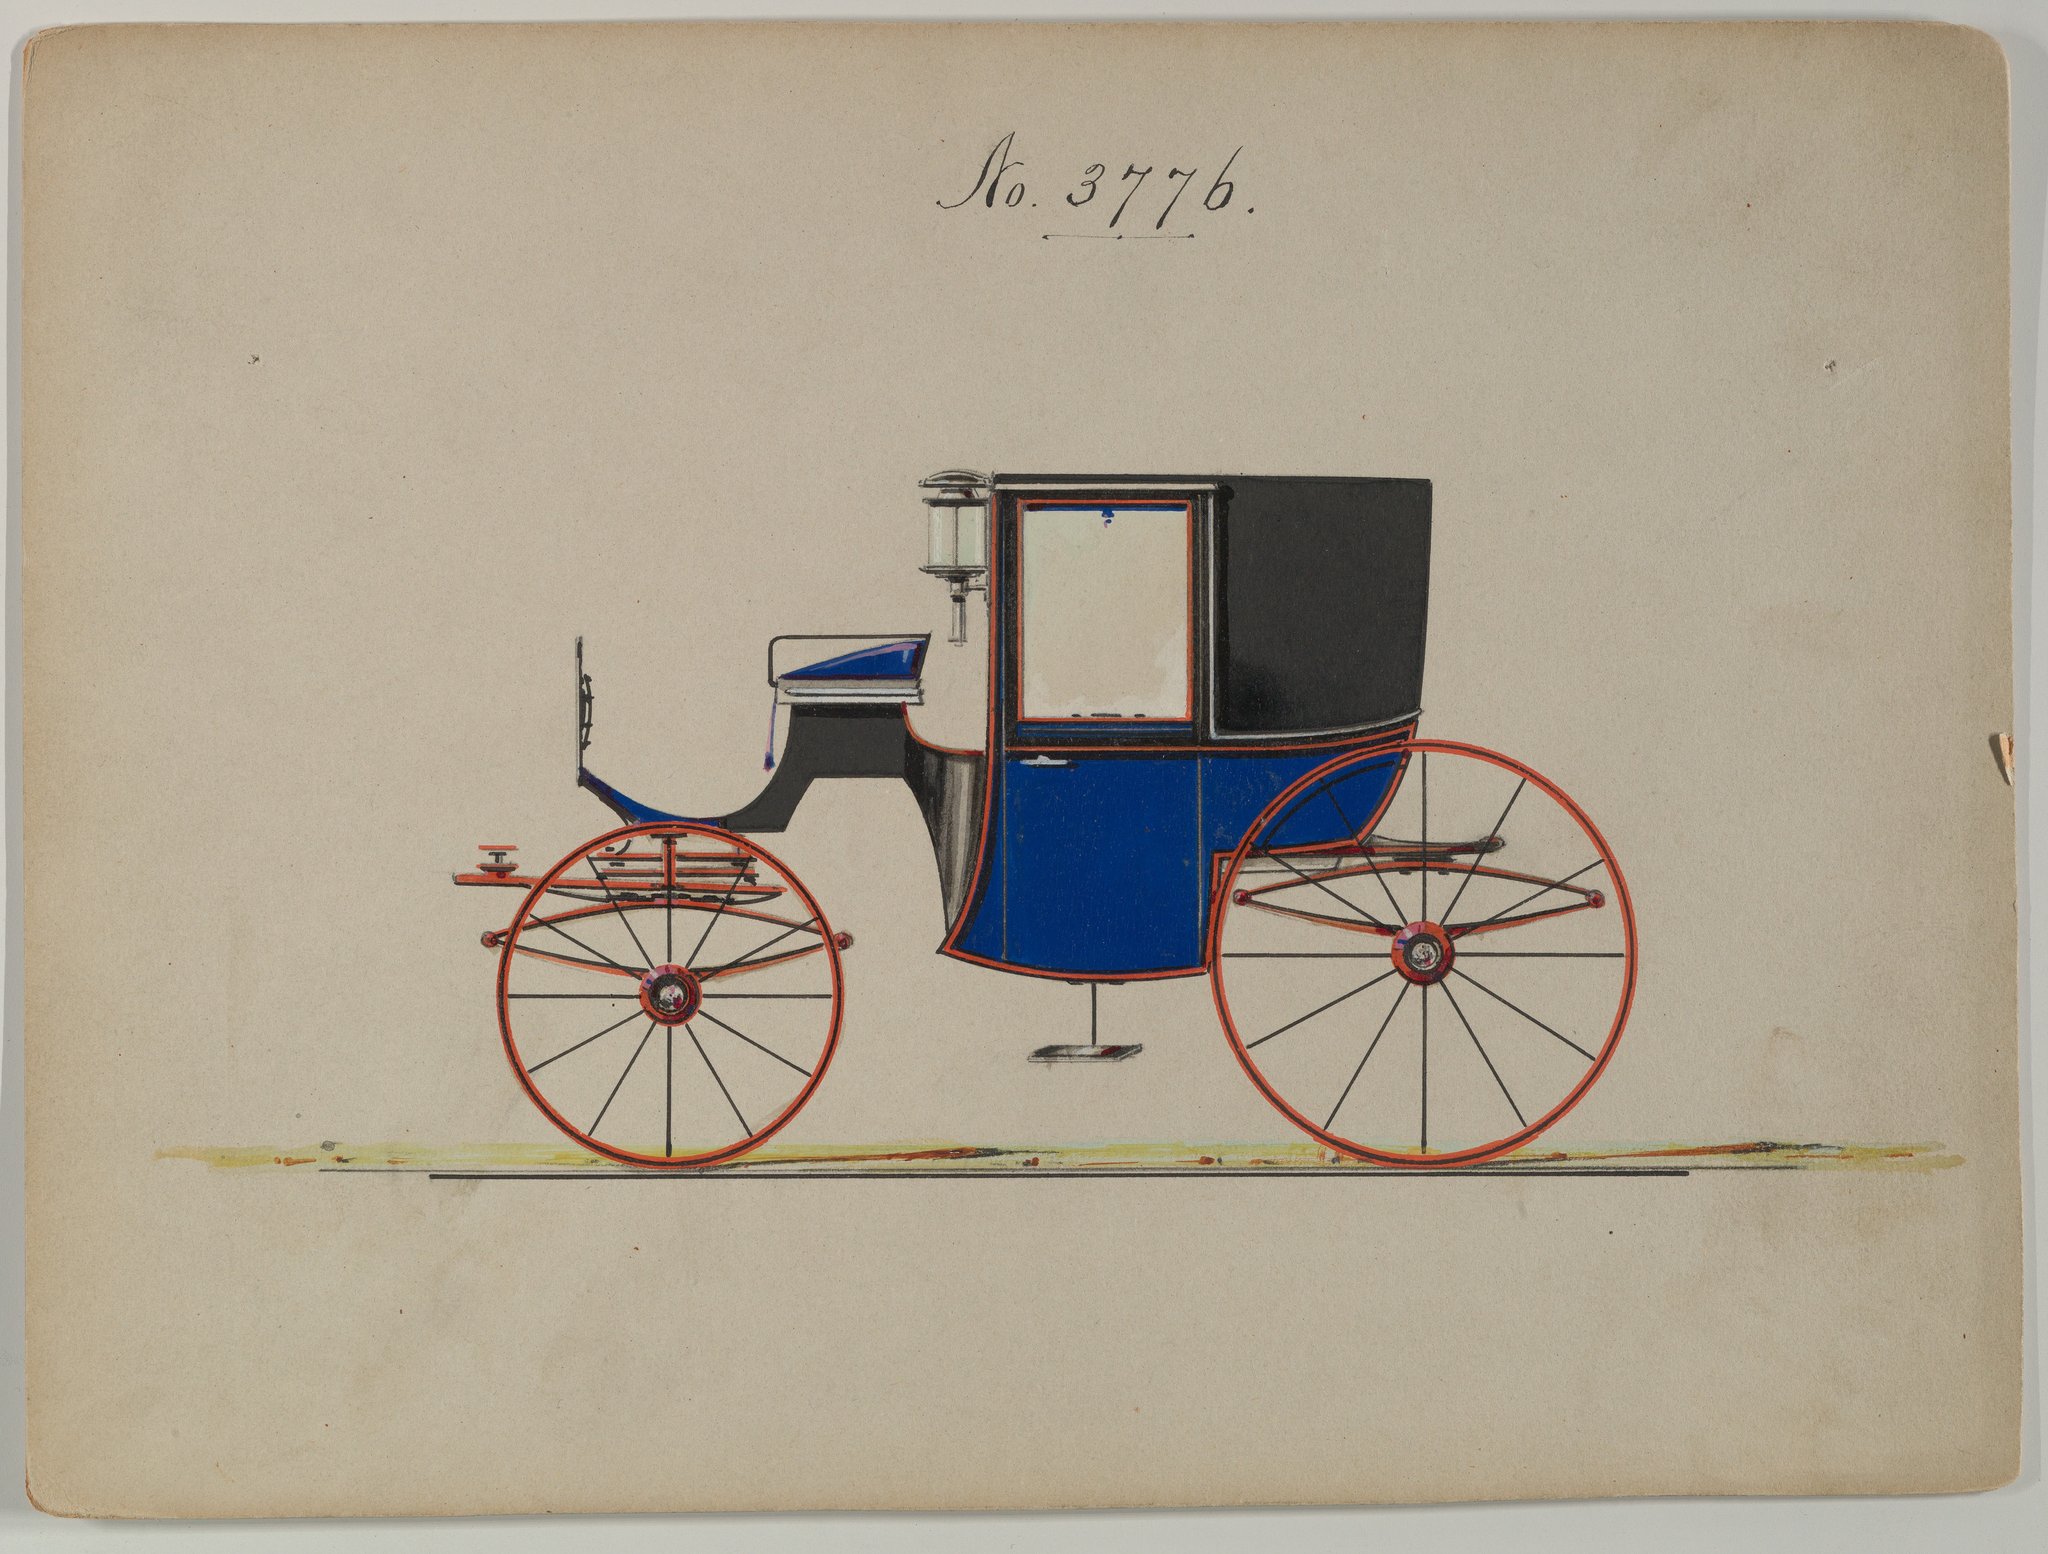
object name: drawing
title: Brougham #3776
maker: brewster & co.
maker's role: manufacturer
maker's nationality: american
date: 1882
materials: gouache, ink, watercolor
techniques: pen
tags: carriages